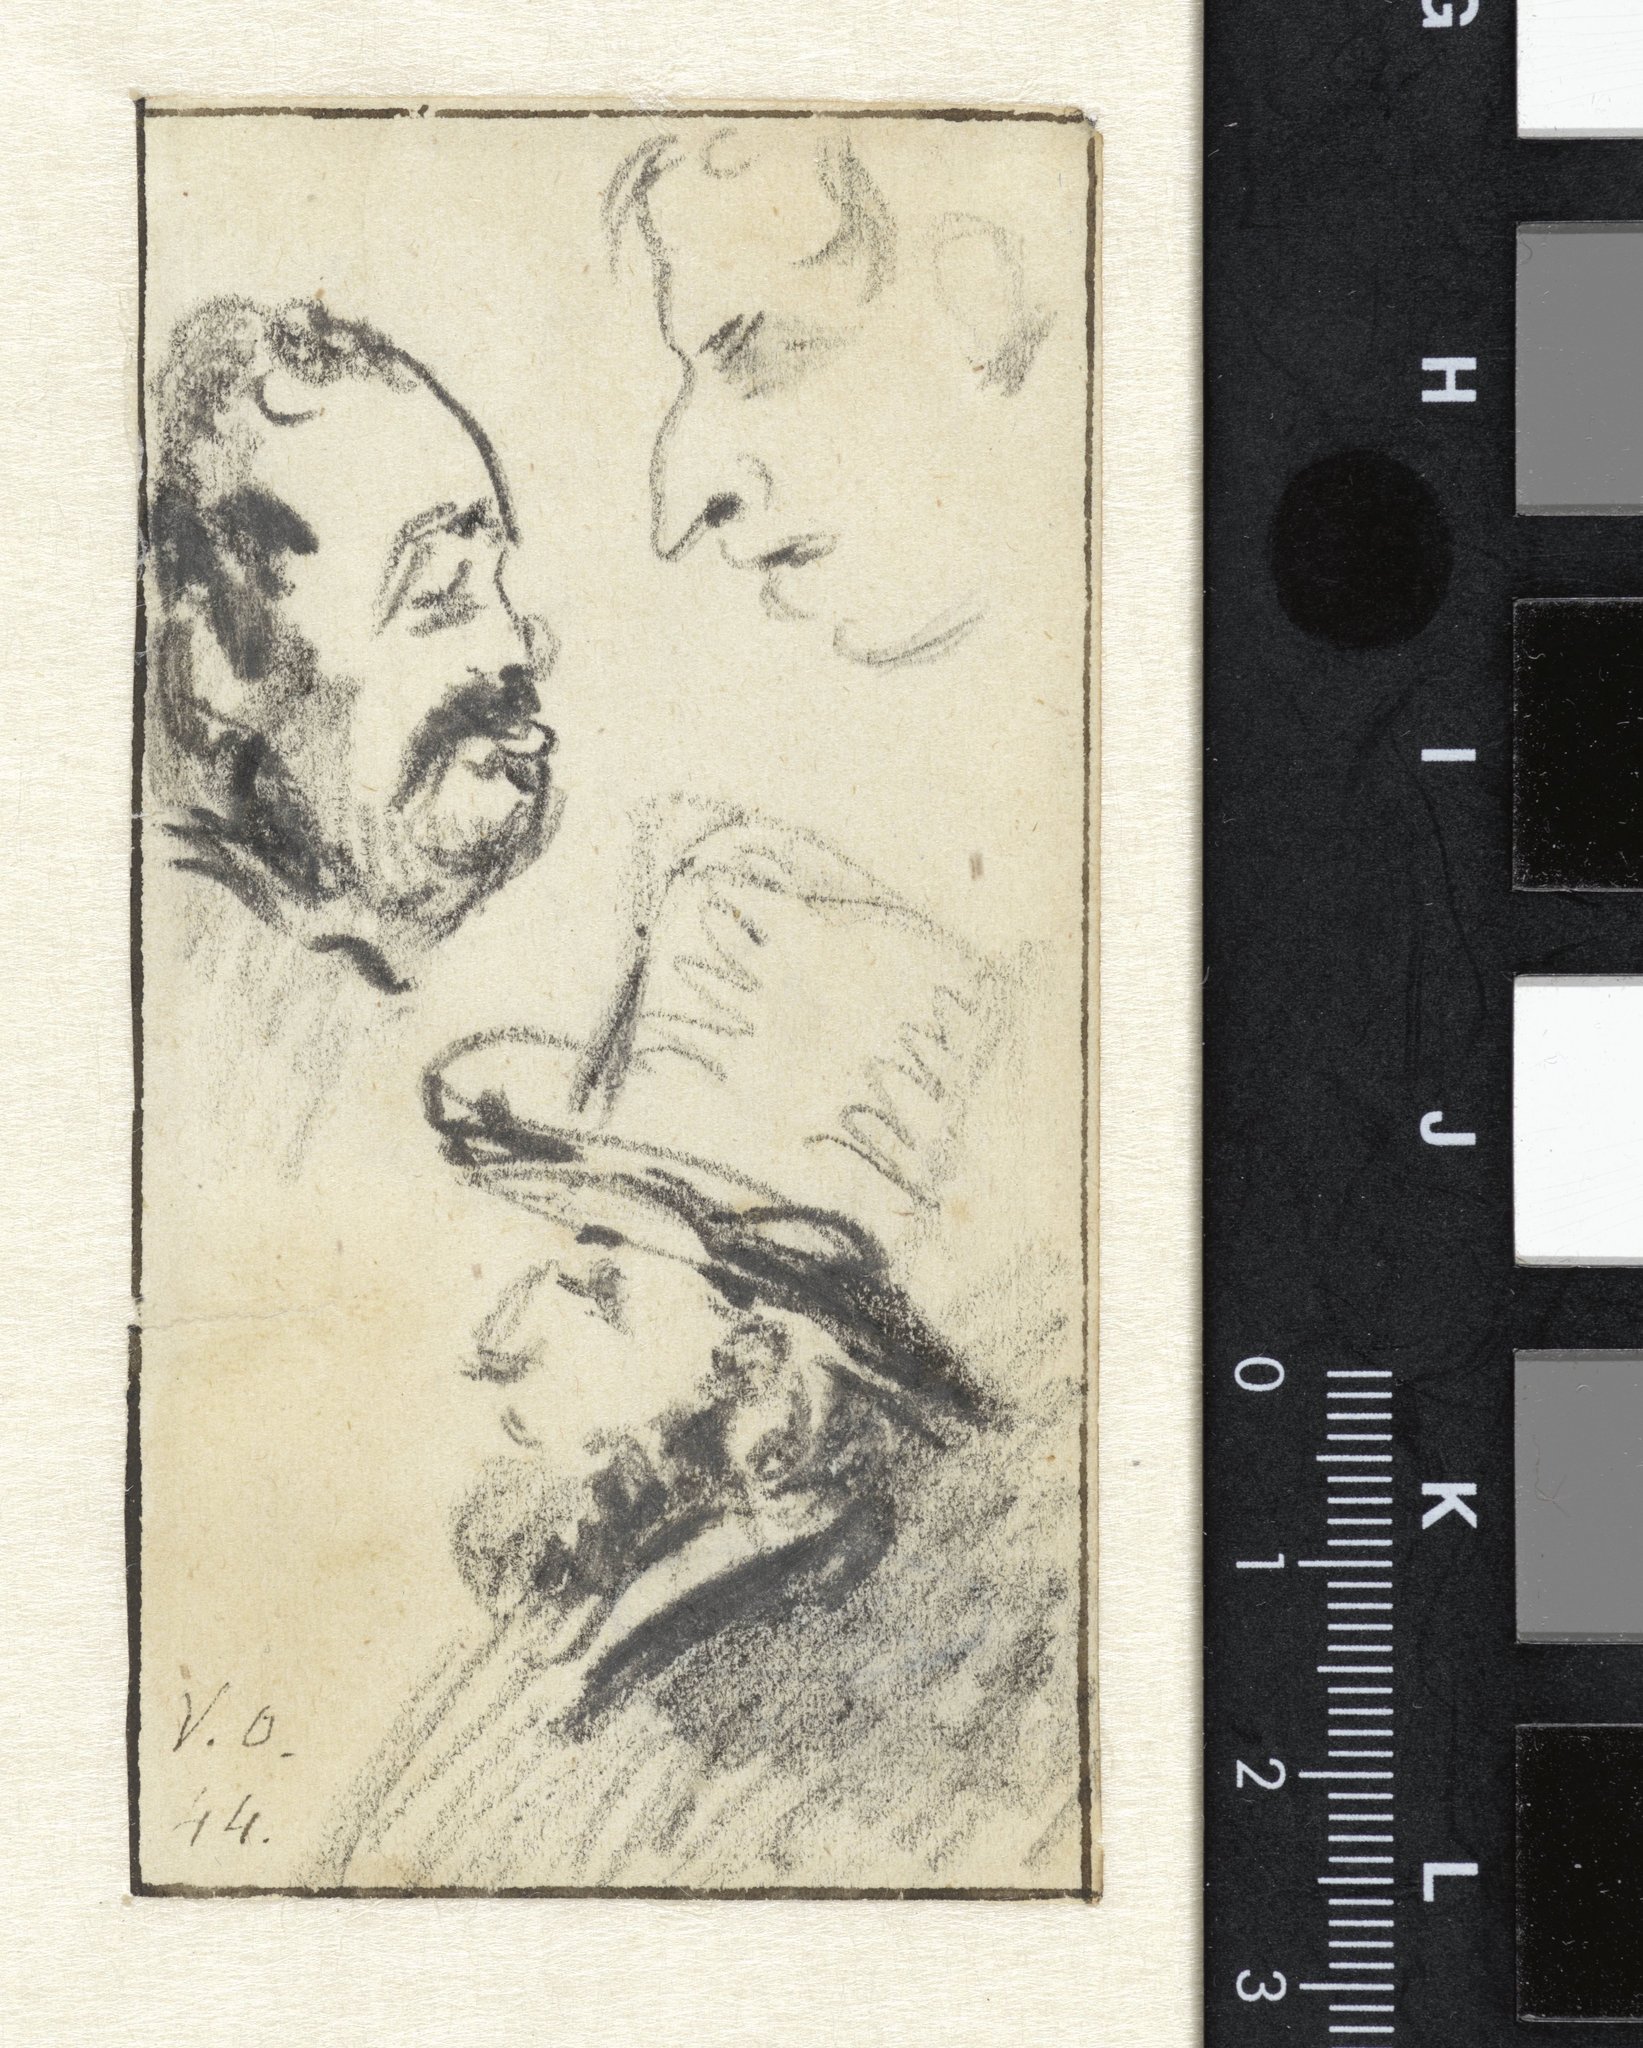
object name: drawing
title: Drie mannenhoofden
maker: georgius jacobus johannes van os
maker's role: draughtsman, painter, print maker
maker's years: 1782-1861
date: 1844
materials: paper, pencil